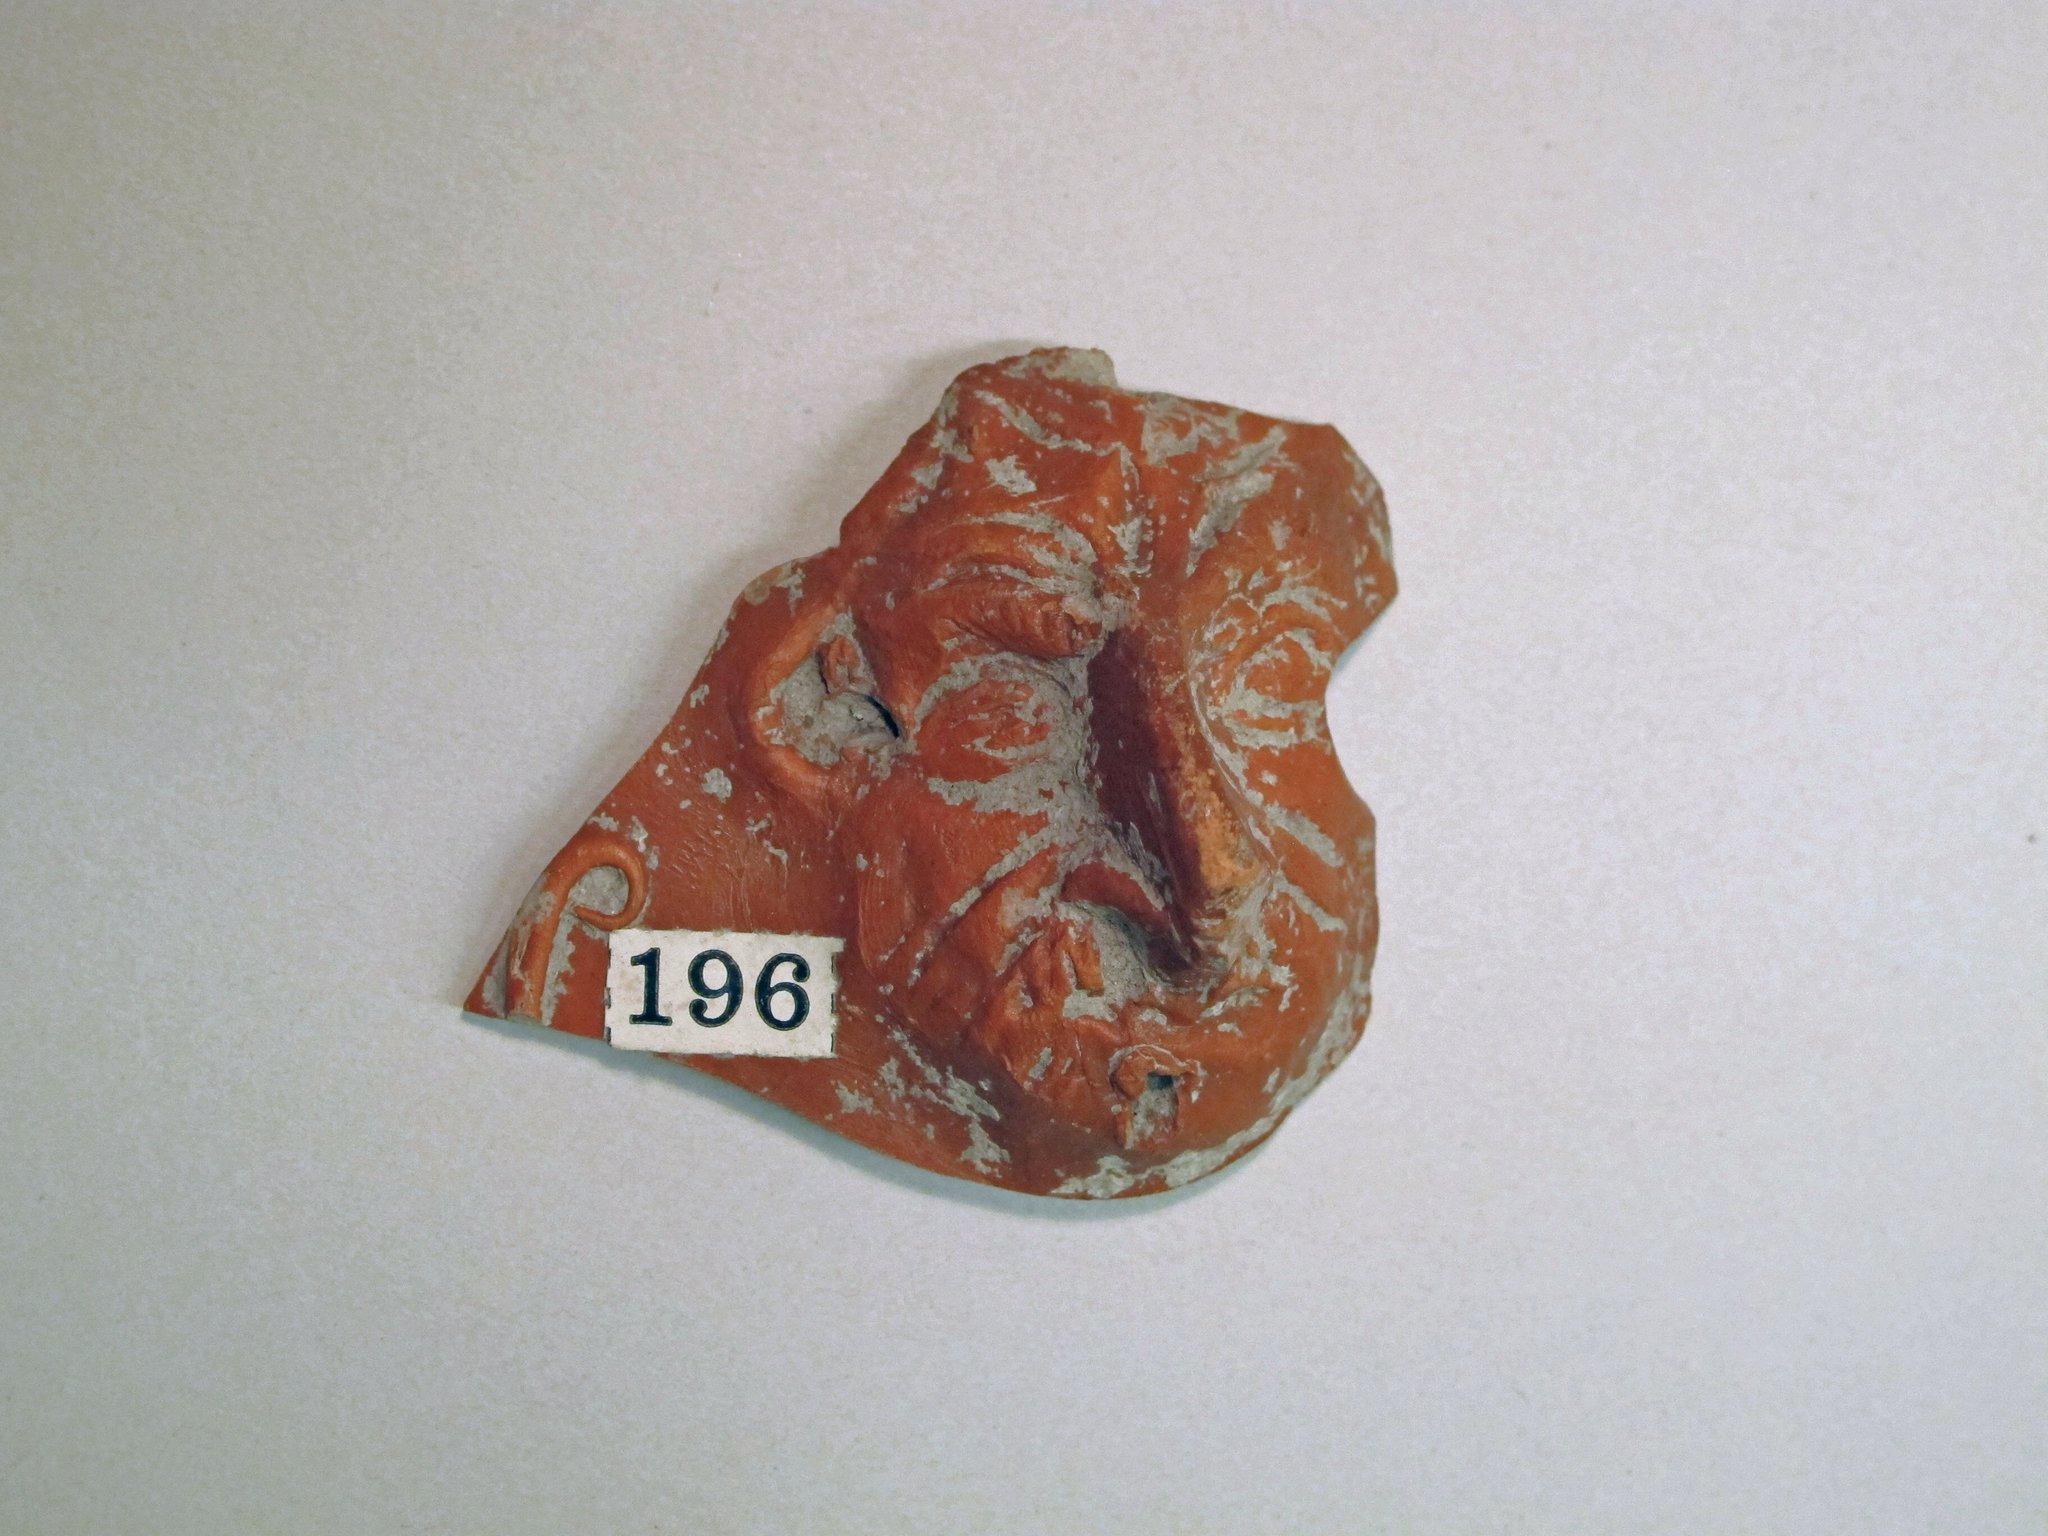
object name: vase fragment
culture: roman, gaul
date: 120 BCE-300 CE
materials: terracotta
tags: faces